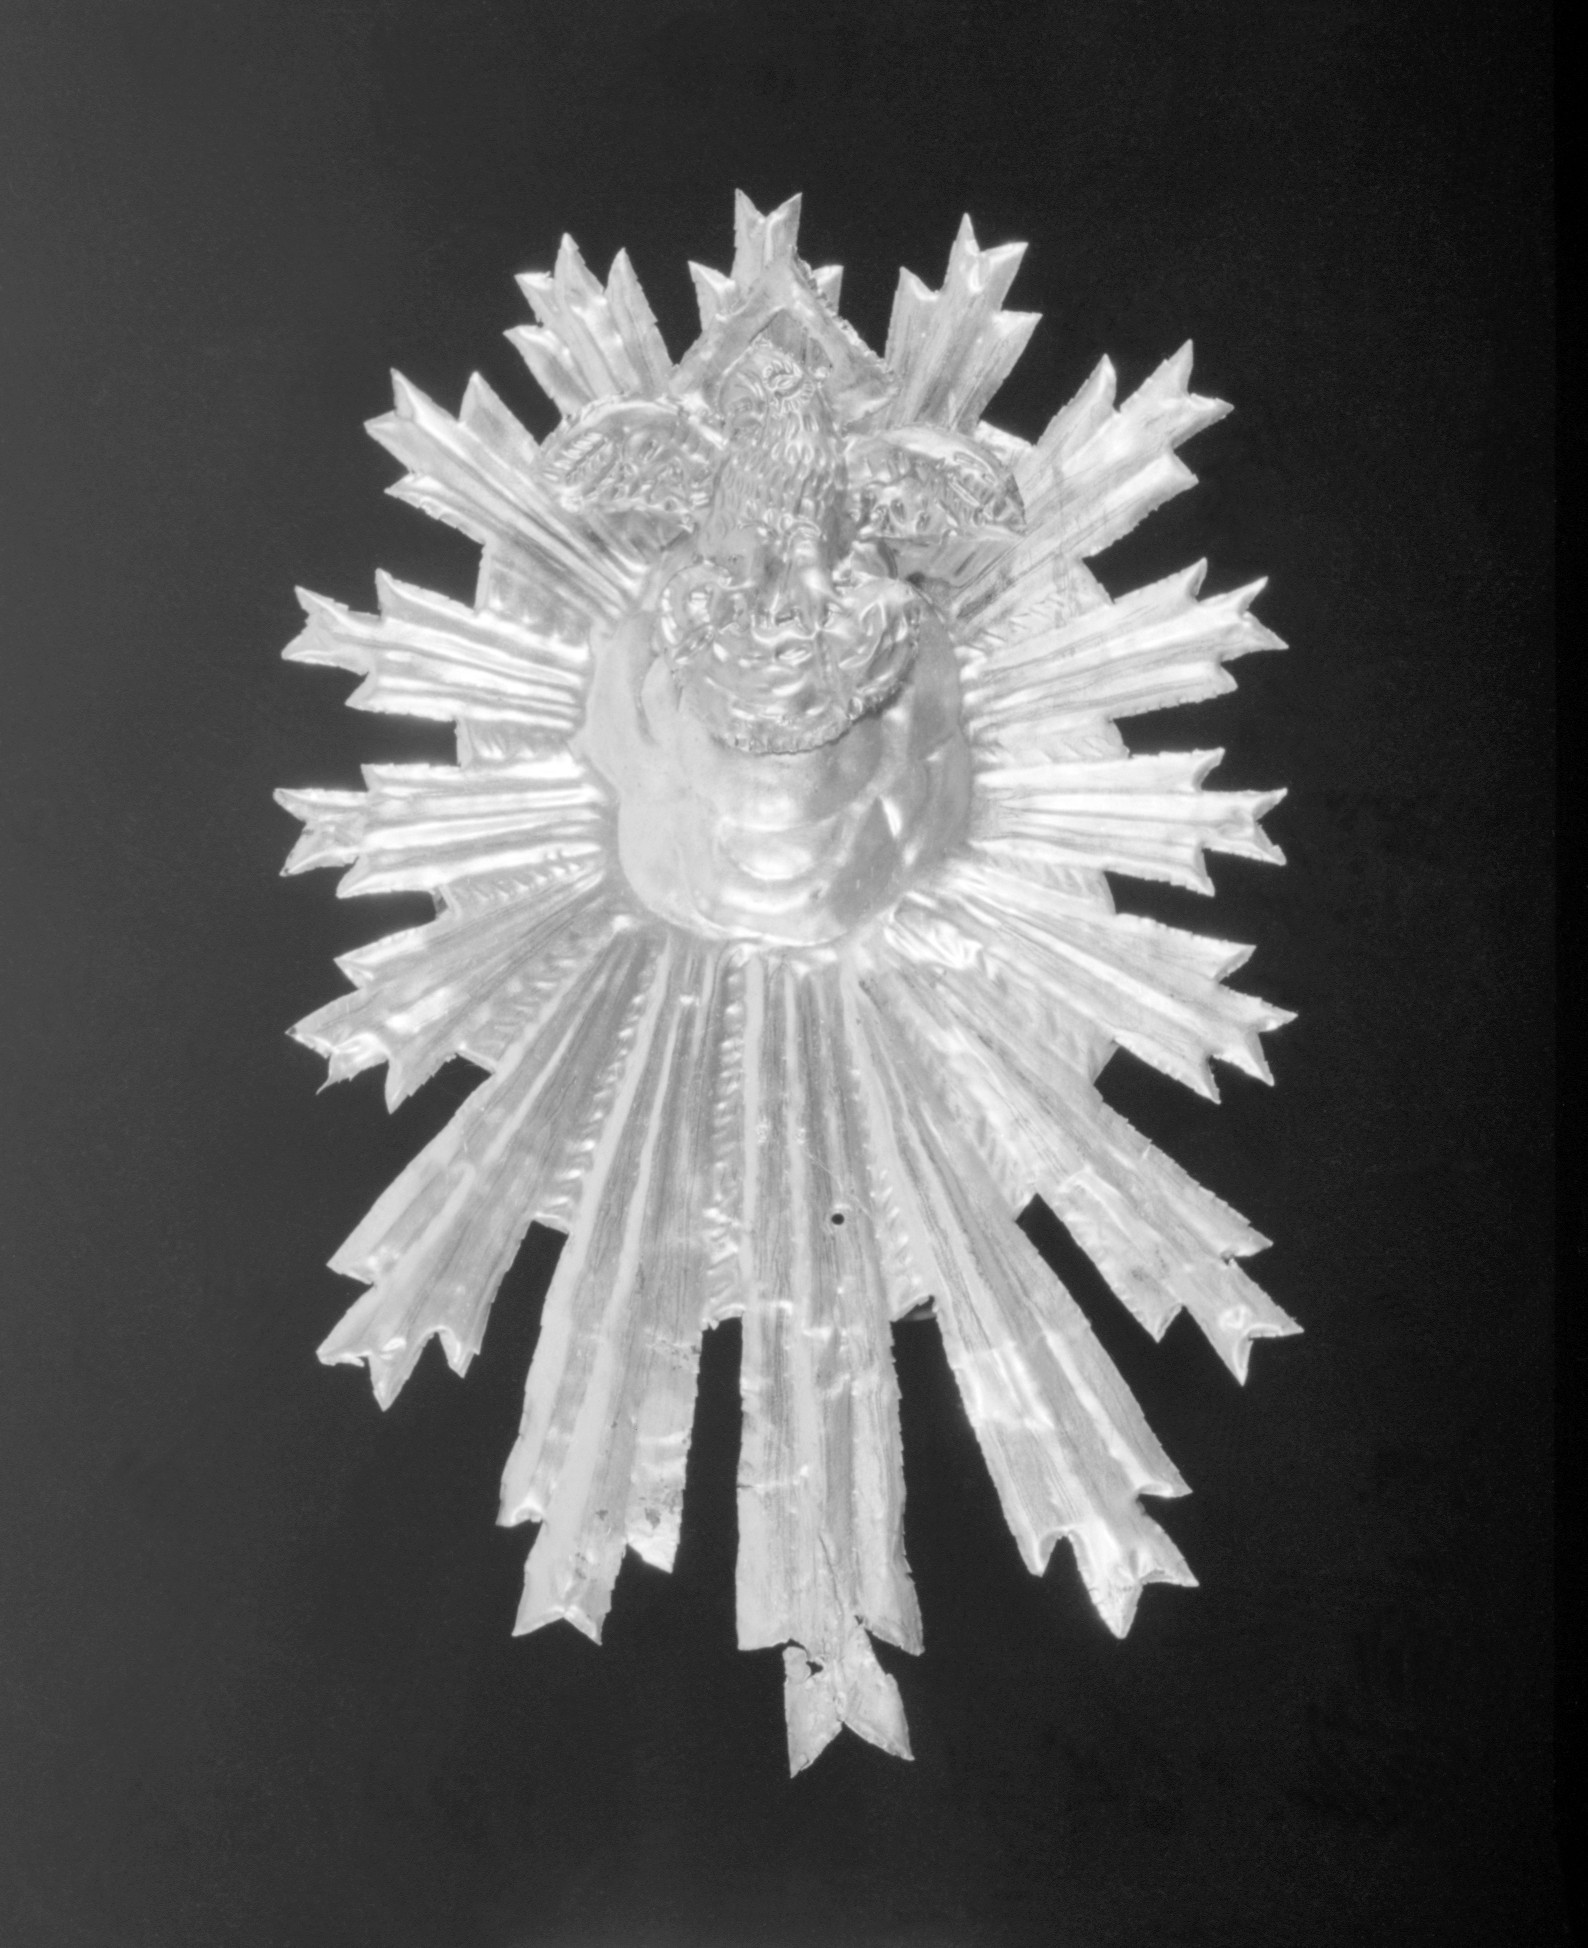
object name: crèche figure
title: Holy Ghost in rays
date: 1751-1800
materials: gilt, tin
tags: birds